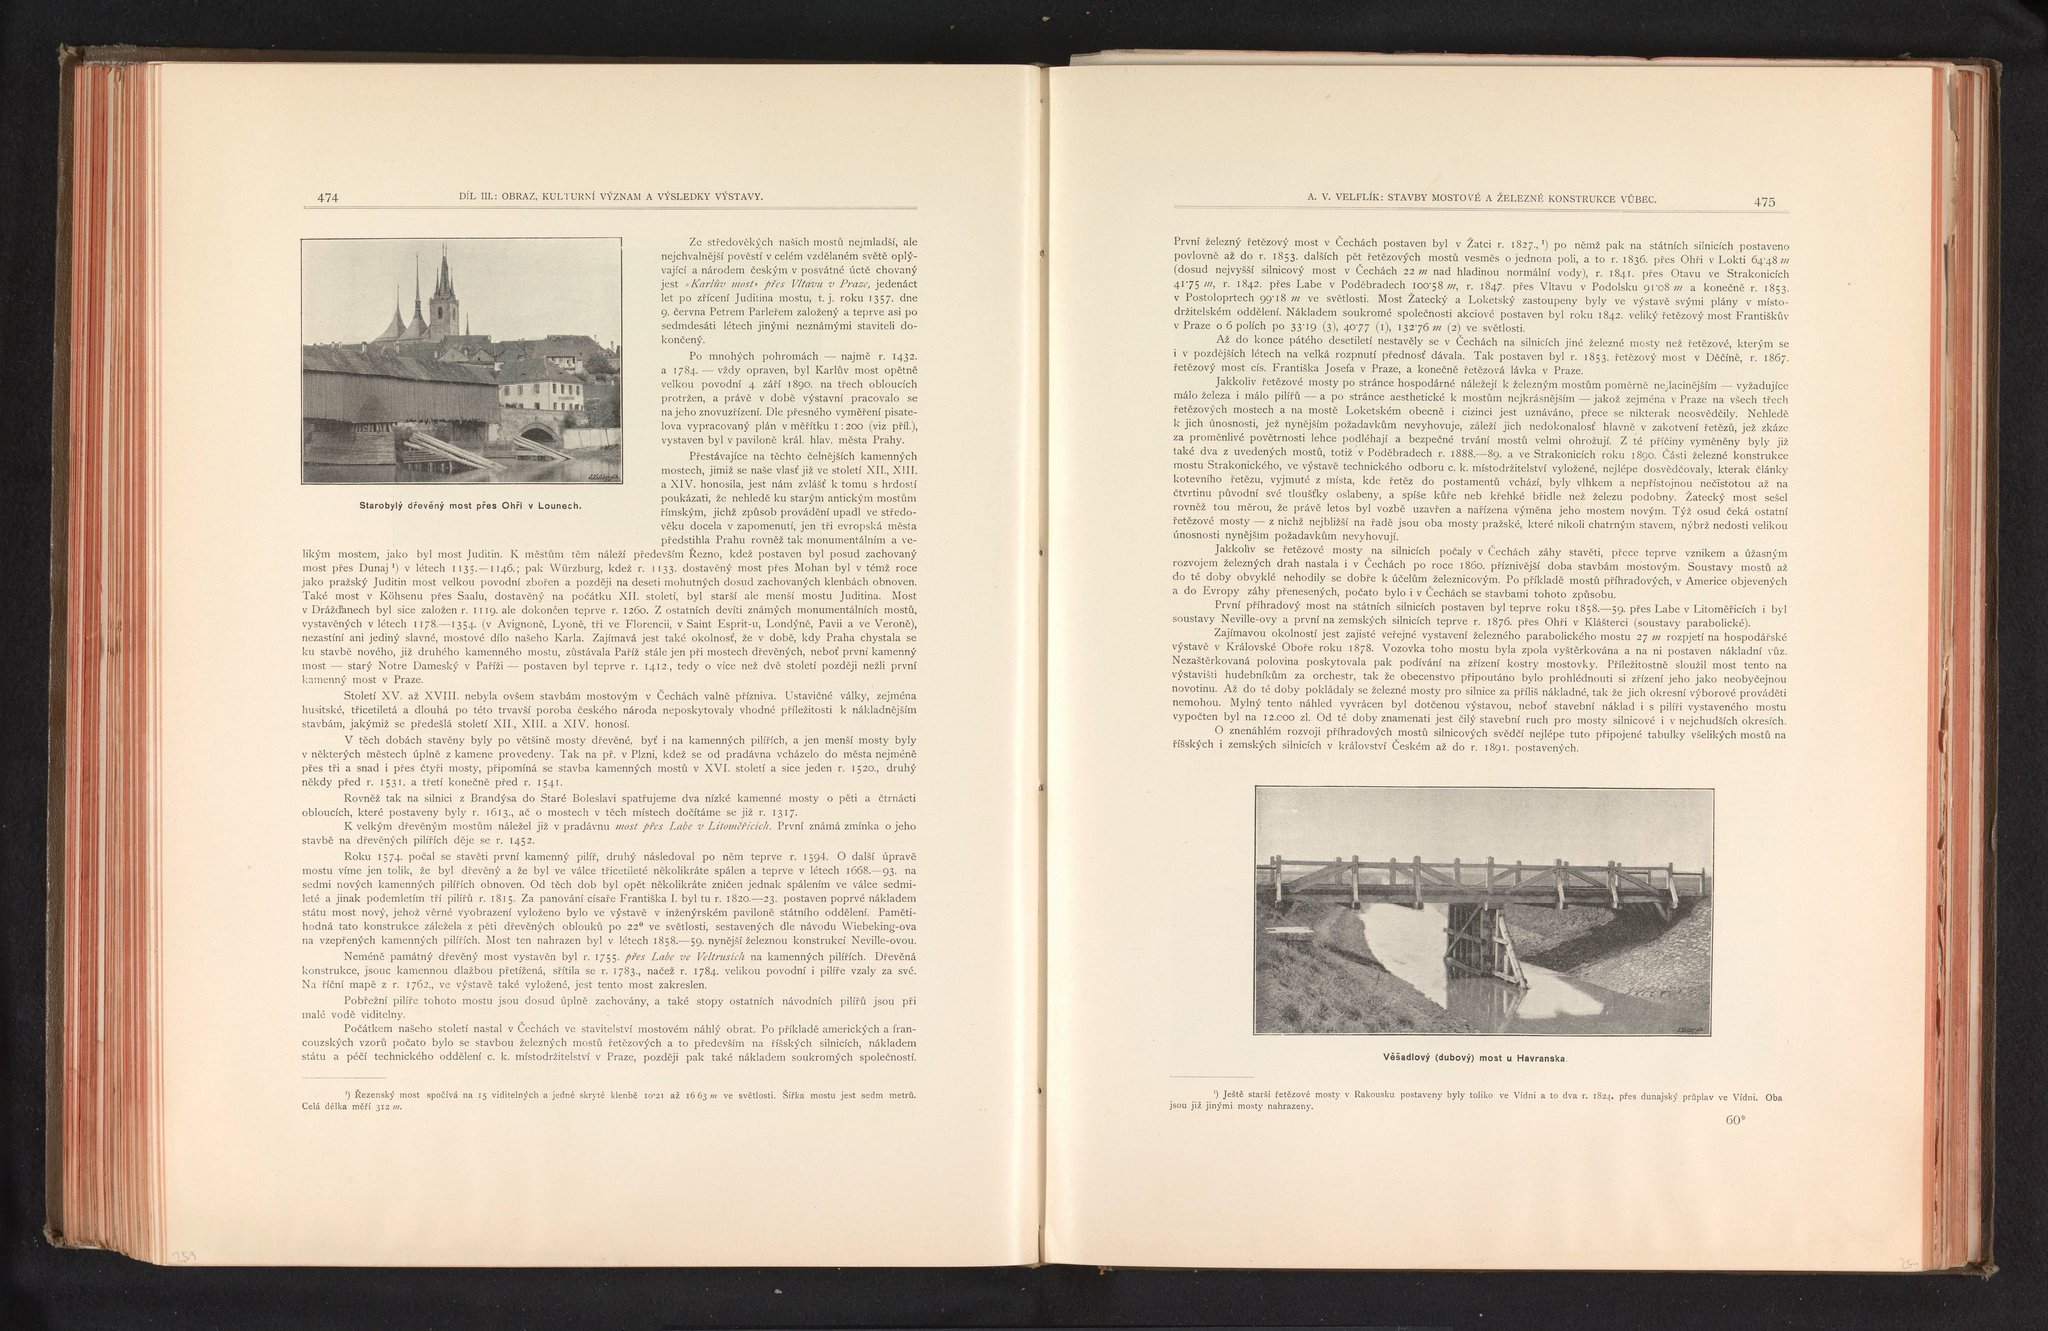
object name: page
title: Houten brug over een rivier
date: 1891-1895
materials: paper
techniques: autotype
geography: czech republic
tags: bridge